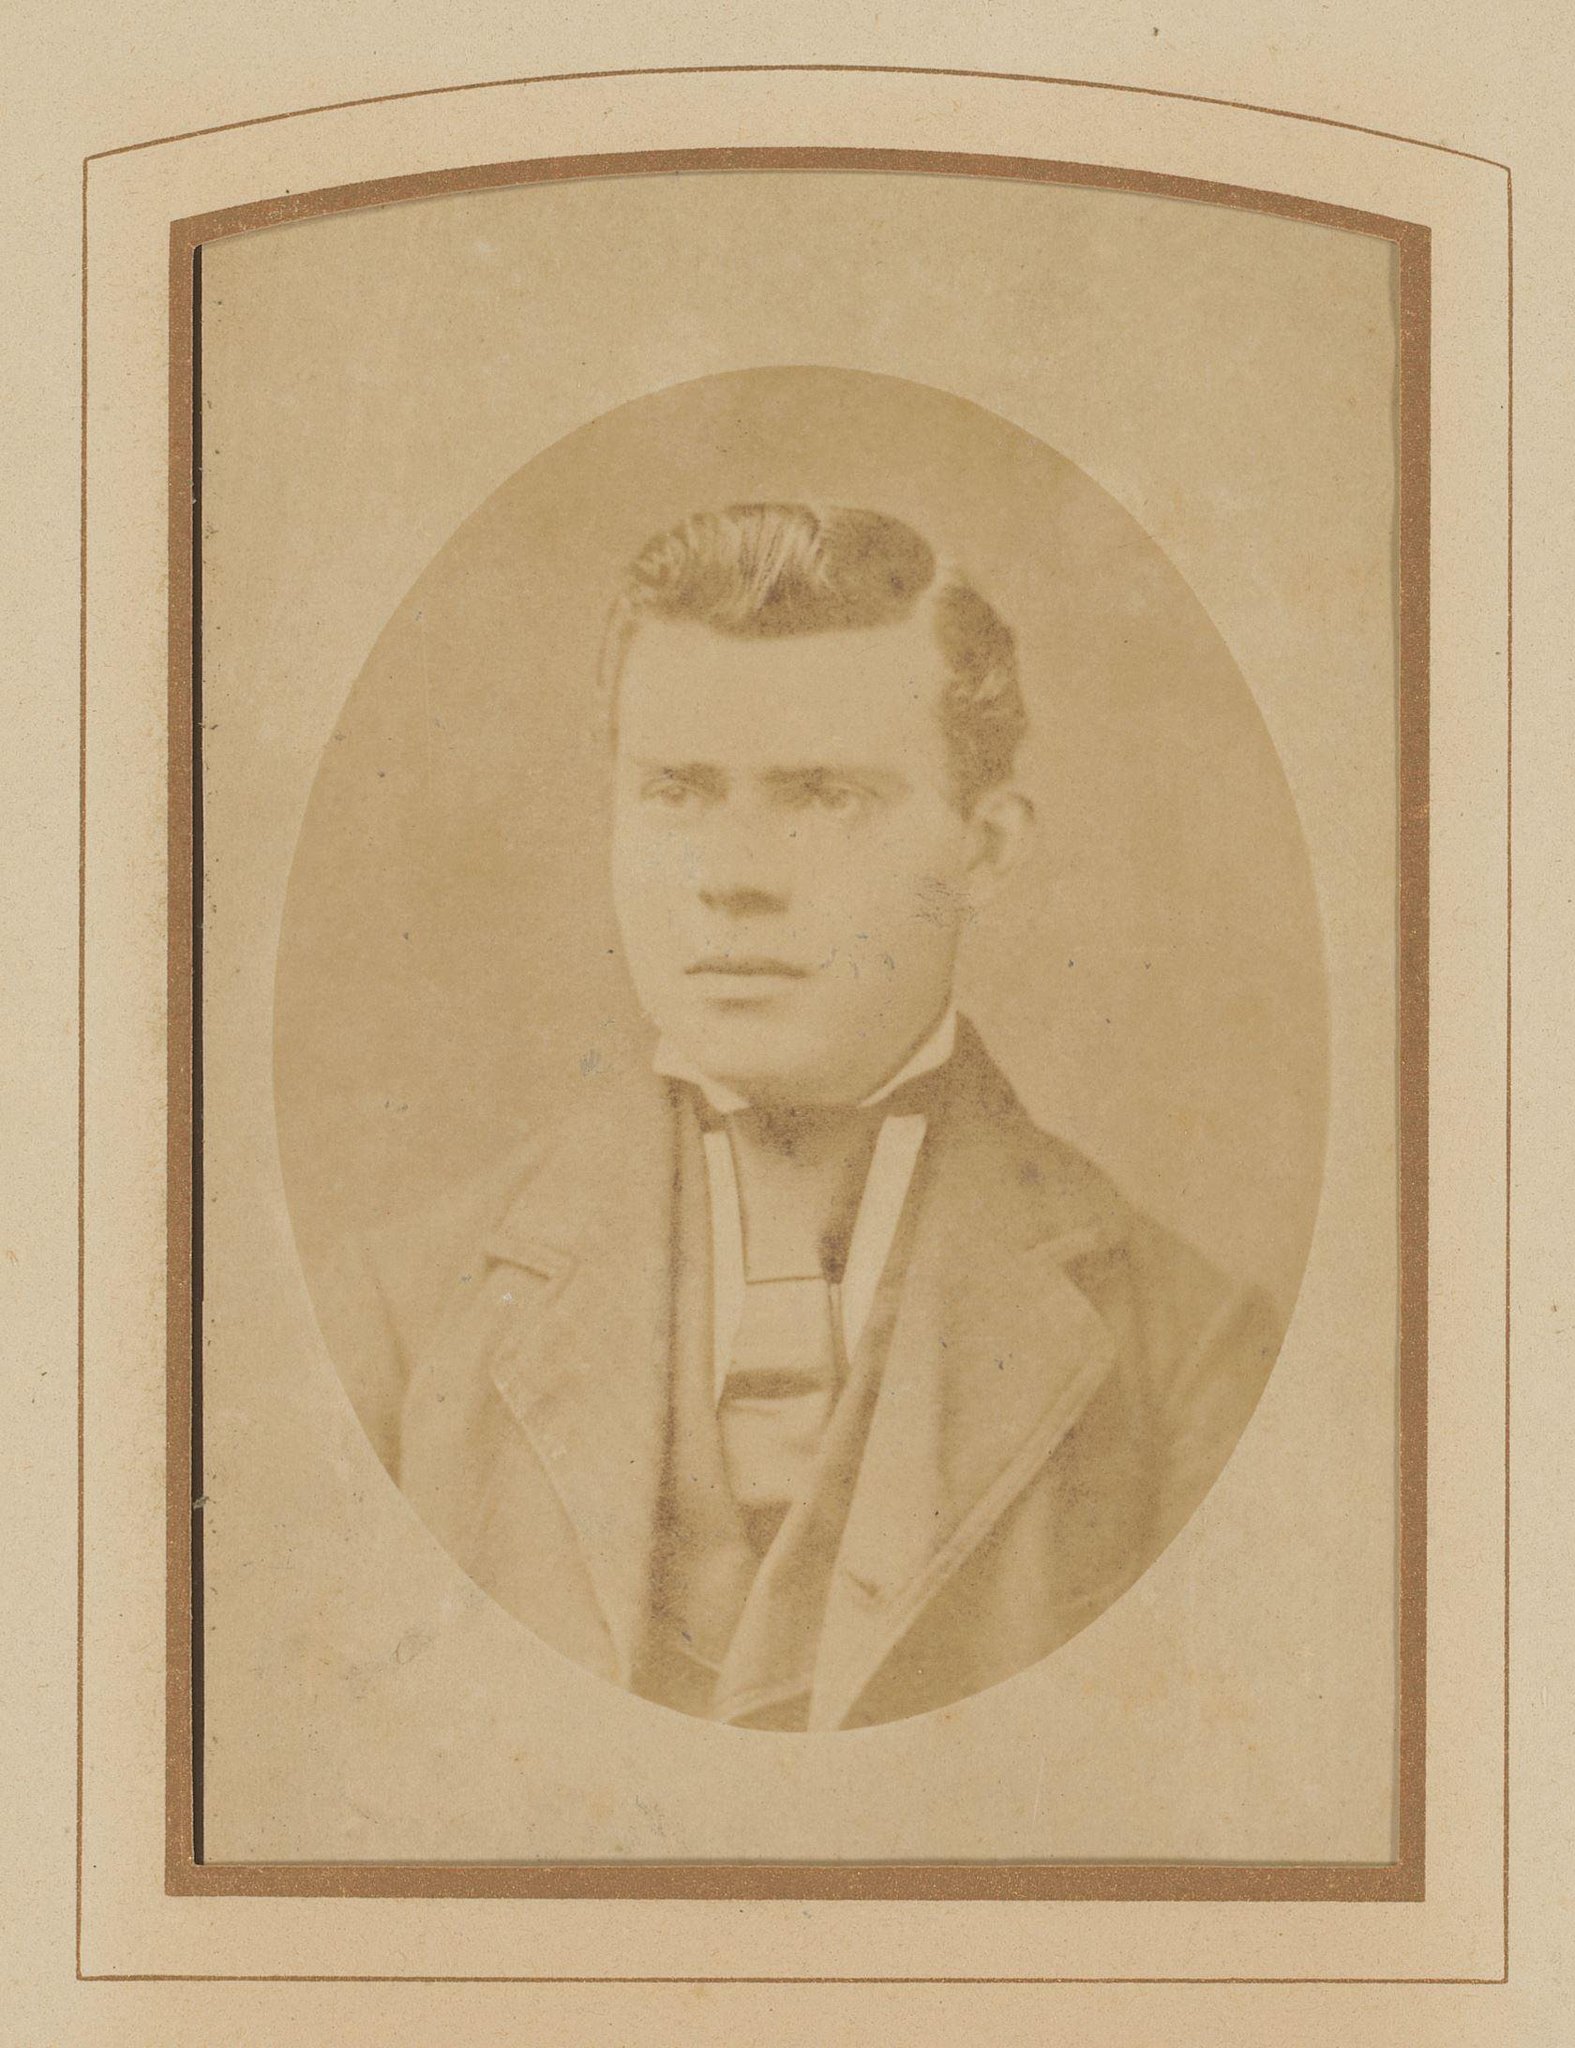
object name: cabinet photograph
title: Portret van een man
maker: Anonymous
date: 1860-1900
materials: cardboard, photographic support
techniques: albumen print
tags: historical persons